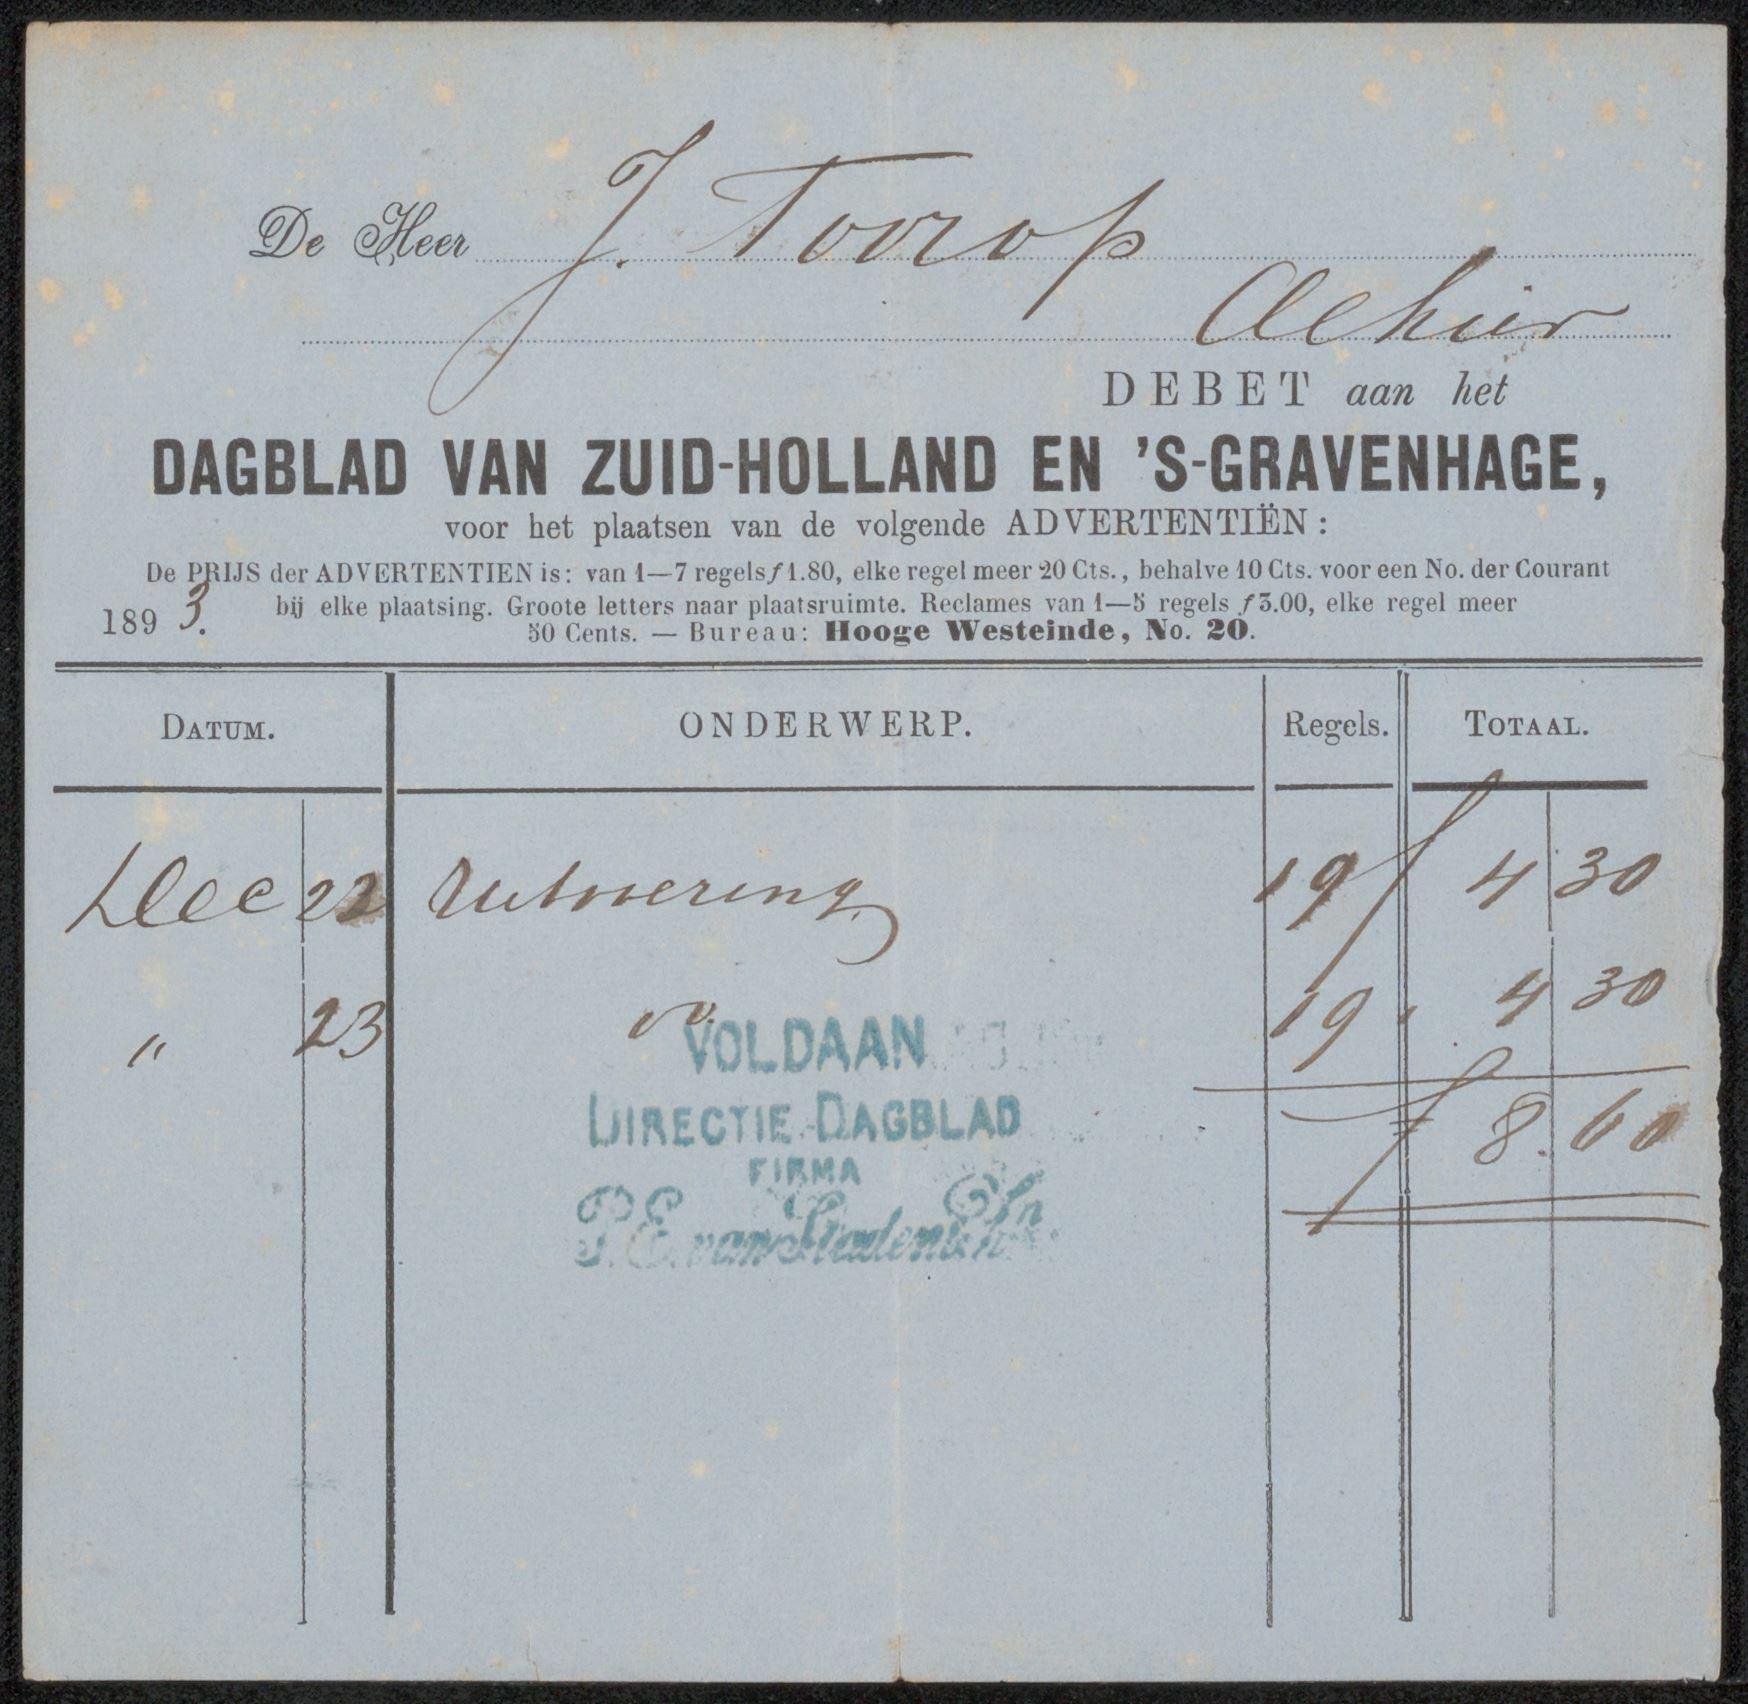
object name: nota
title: Nota aan Jan Toorop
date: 1893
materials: ink, paper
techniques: pen, printing, writing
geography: the hague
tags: painter, jan toorop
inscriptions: collector's mark: ‘RPK’, stamp: ‘VOLDAAN/ DIRECTIE DAGBLAD/ FIRMA/ P.E. van Staden & Zn’